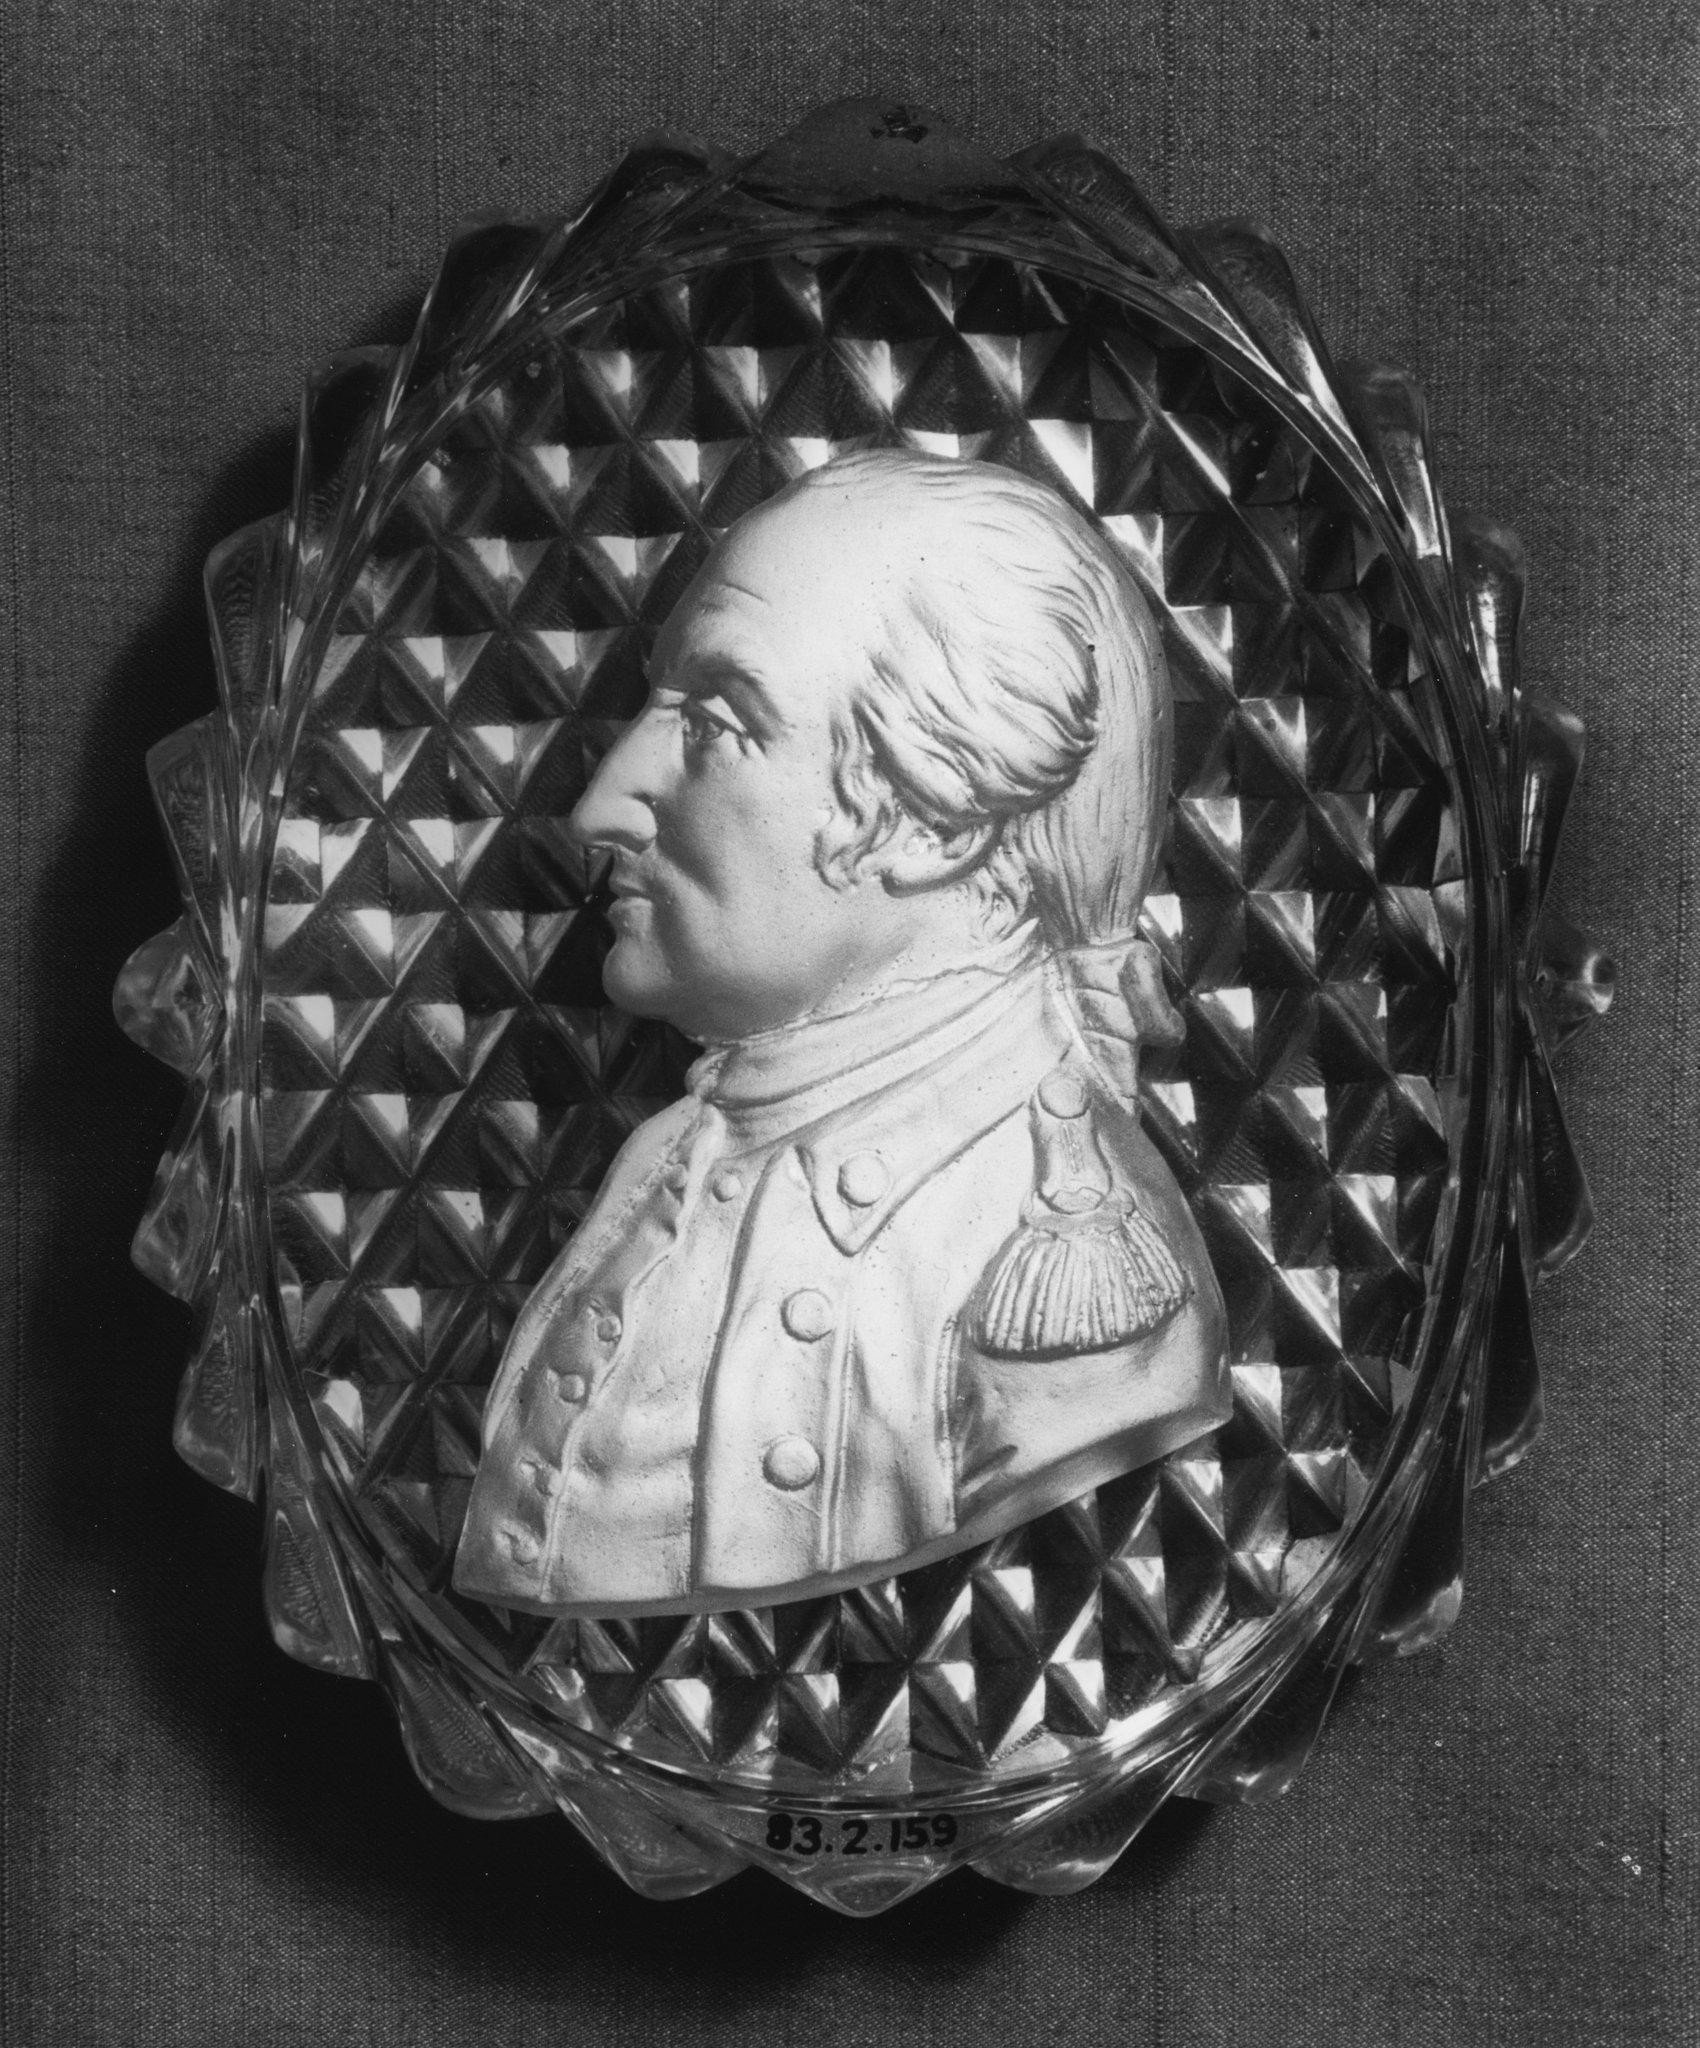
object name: medallion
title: George Washington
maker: desprez jr.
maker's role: maker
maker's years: 1819-1830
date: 1820-1830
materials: glass, porcelain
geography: france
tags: george washington,profiles